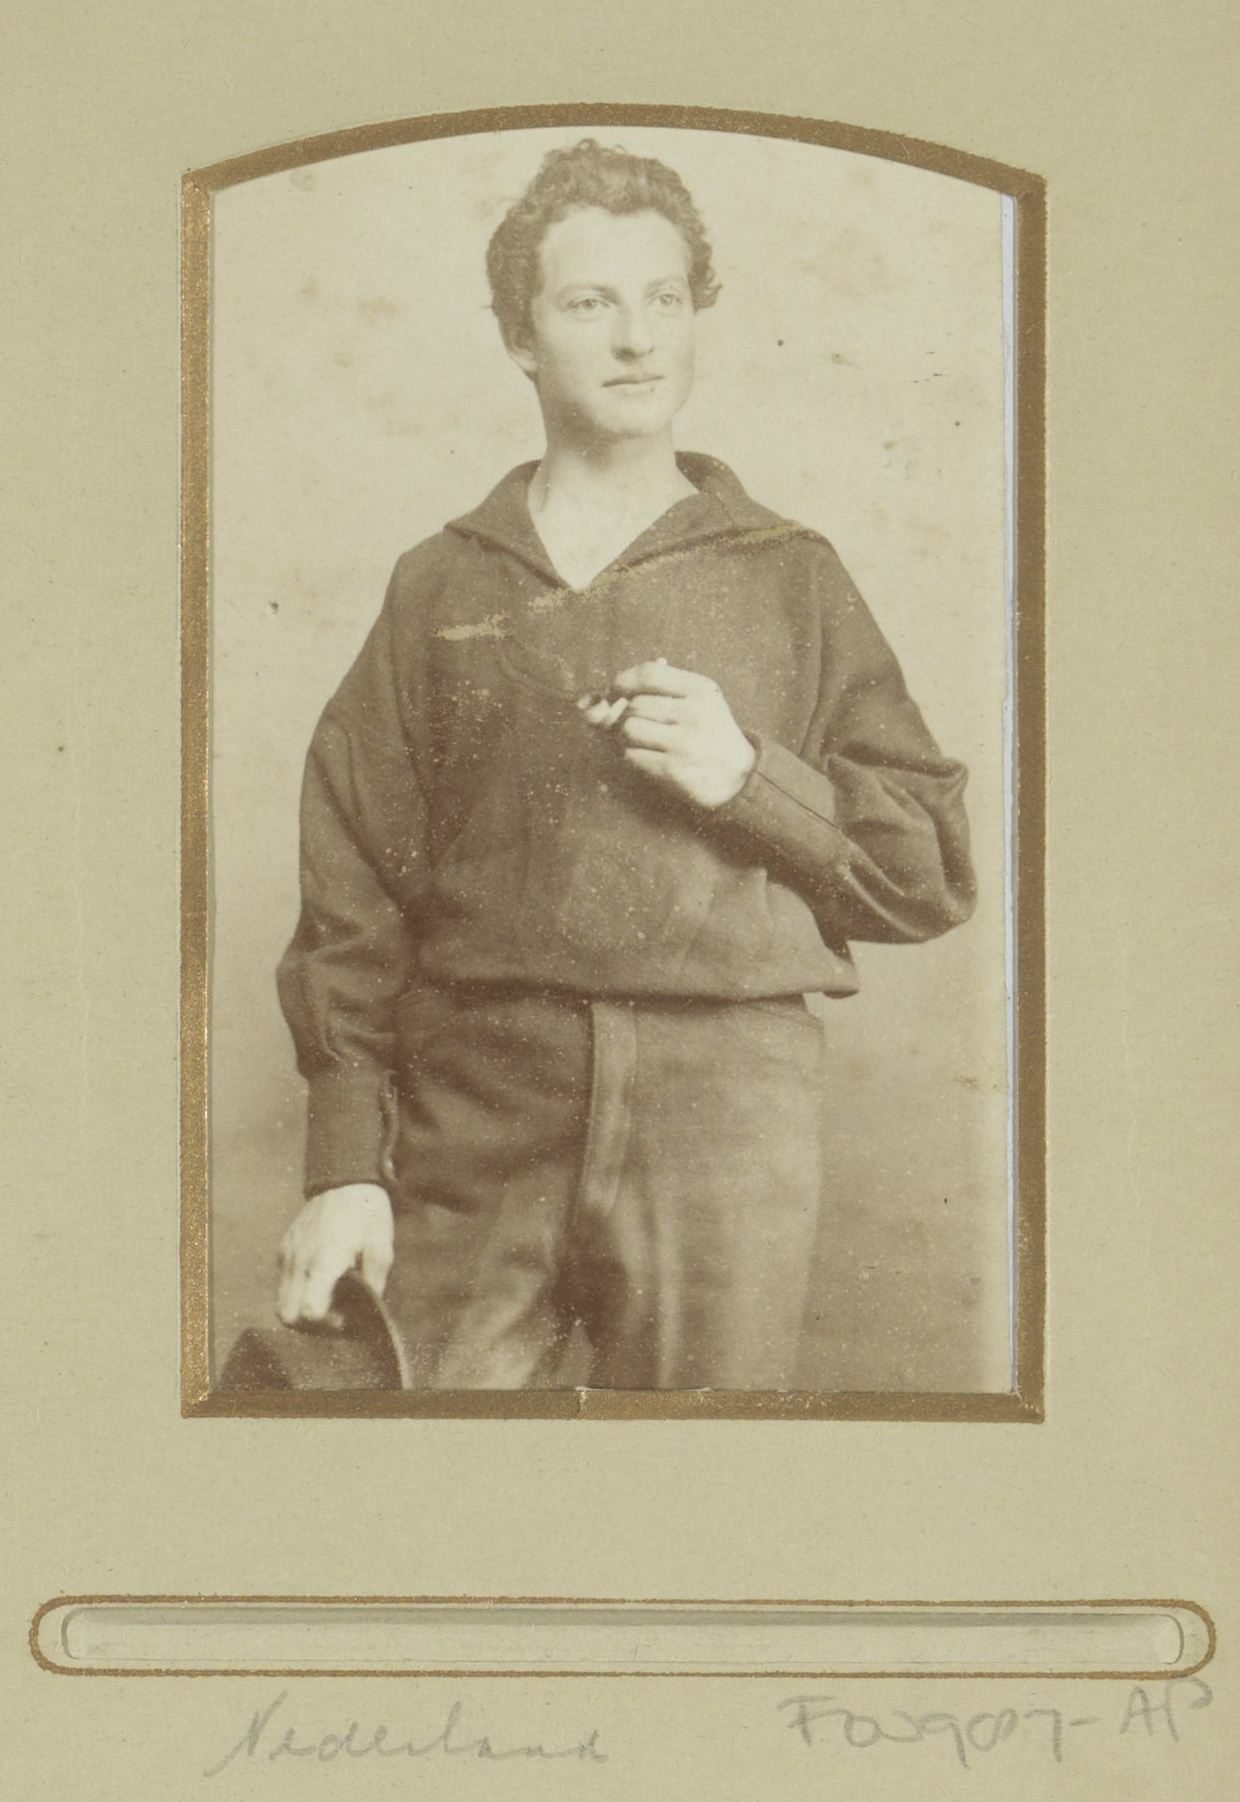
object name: album leaf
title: Portret van een (vermoedelijk) Engelse matroos, staand met hoed en pijp in de hand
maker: a.f. vogel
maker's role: fotograaf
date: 1870-1900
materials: cardboard, paper, photographic support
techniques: albumen print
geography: liverpool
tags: pipe ~ tobacco, navy, warfare; military affairs, (military) uniforms, division of armed forces, liverpool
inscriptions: address: ‘7. Parkerstreet Liverpool’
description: Onderdeel van Album met cartes-de-visite en kabinetfoto's van militairen in uniform.